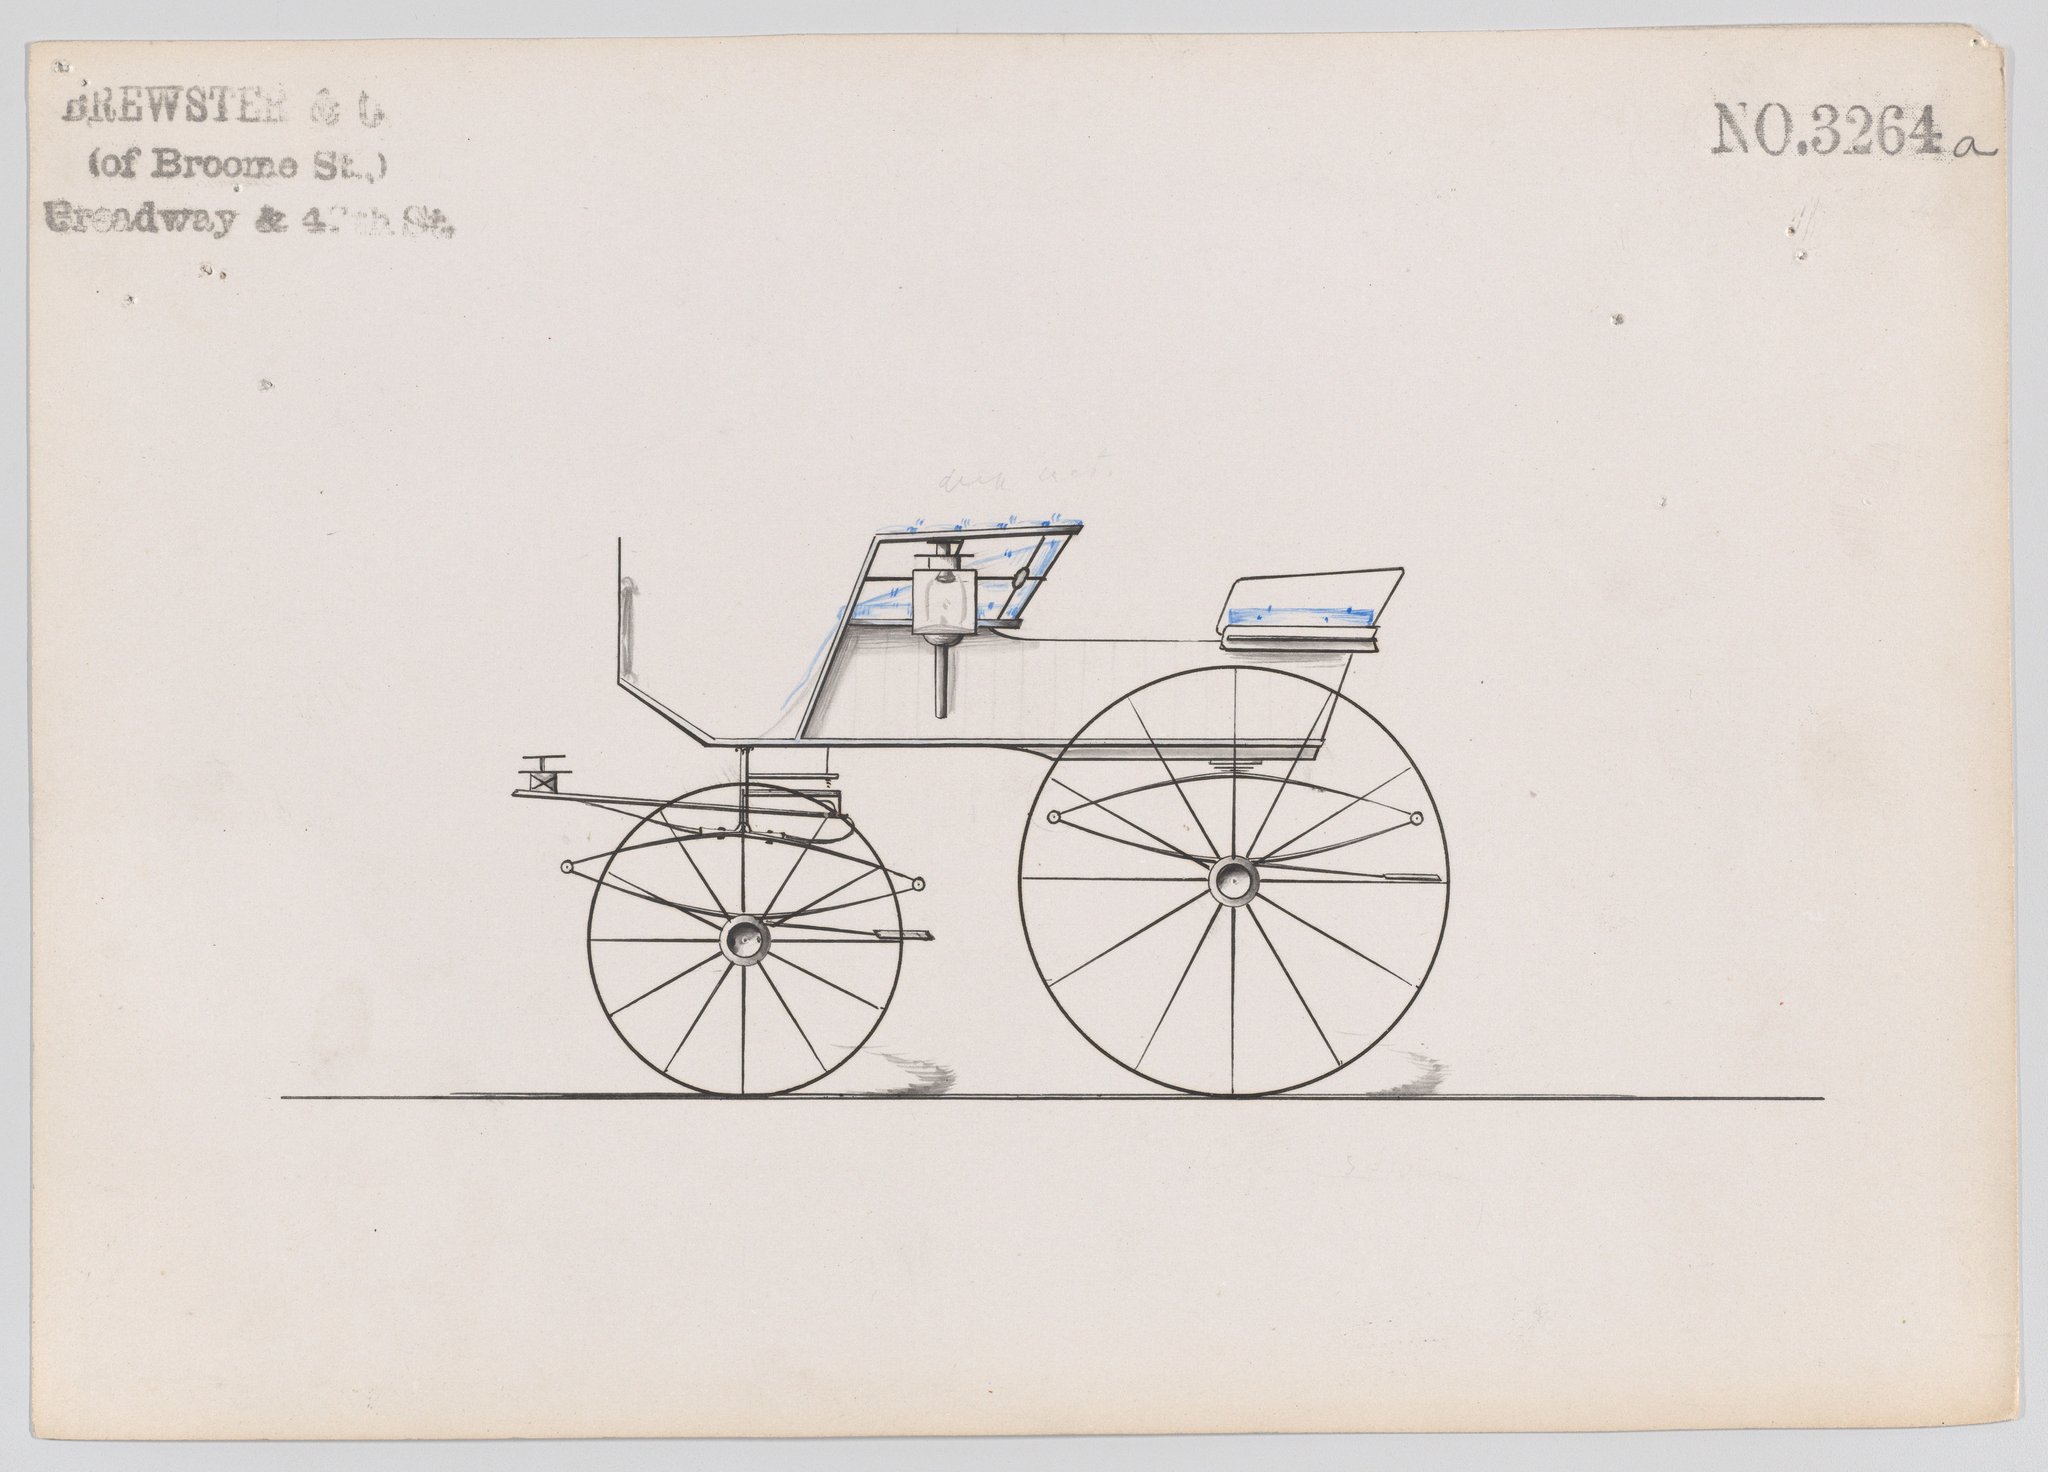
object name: drawing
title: Design for T-Cart, no. 3264a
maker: brewster & co.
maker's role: manufacturer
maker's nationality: american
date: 1876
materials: gouache, ink, watercolor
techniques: pen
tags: carriages